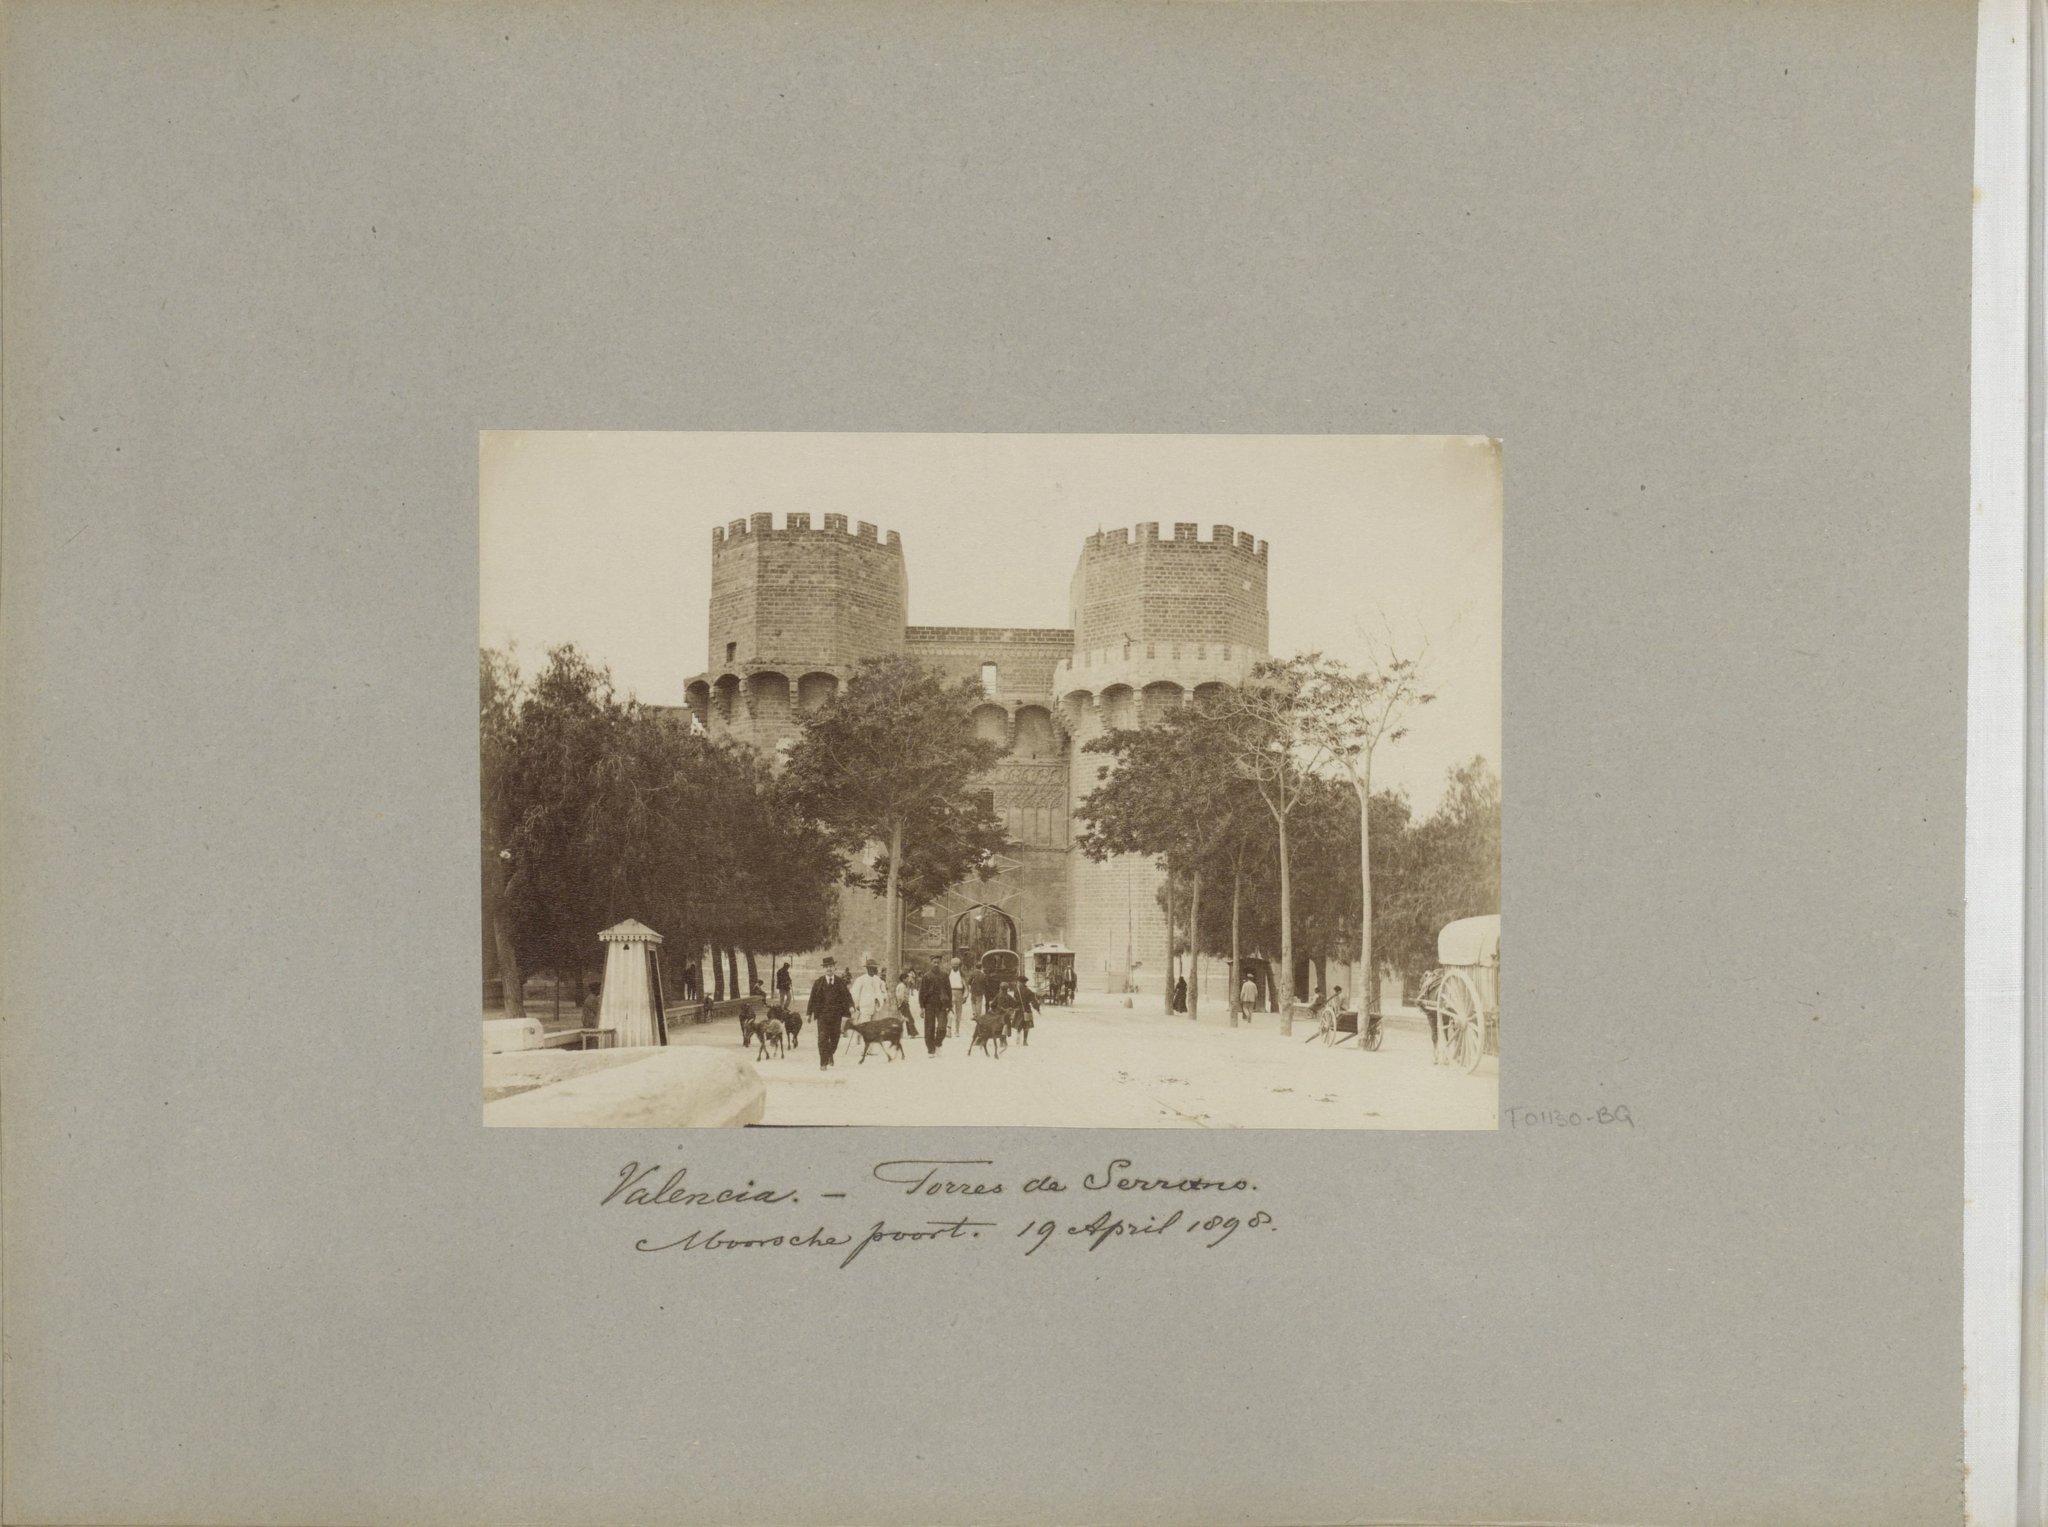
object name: photograph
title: Gezicht op de Torres de Serranos in Valencia met voorbijgangers, geiten en karren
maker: Anonymous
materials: paper, photographic support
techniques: albumen print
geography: valencia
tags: city-gate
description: Onderdeel van Reisalbum met foto's van bezienswaardigheden in Frankrijk, Spanje, Italië, Duitsland, Zwitserland en Oostenrijk.